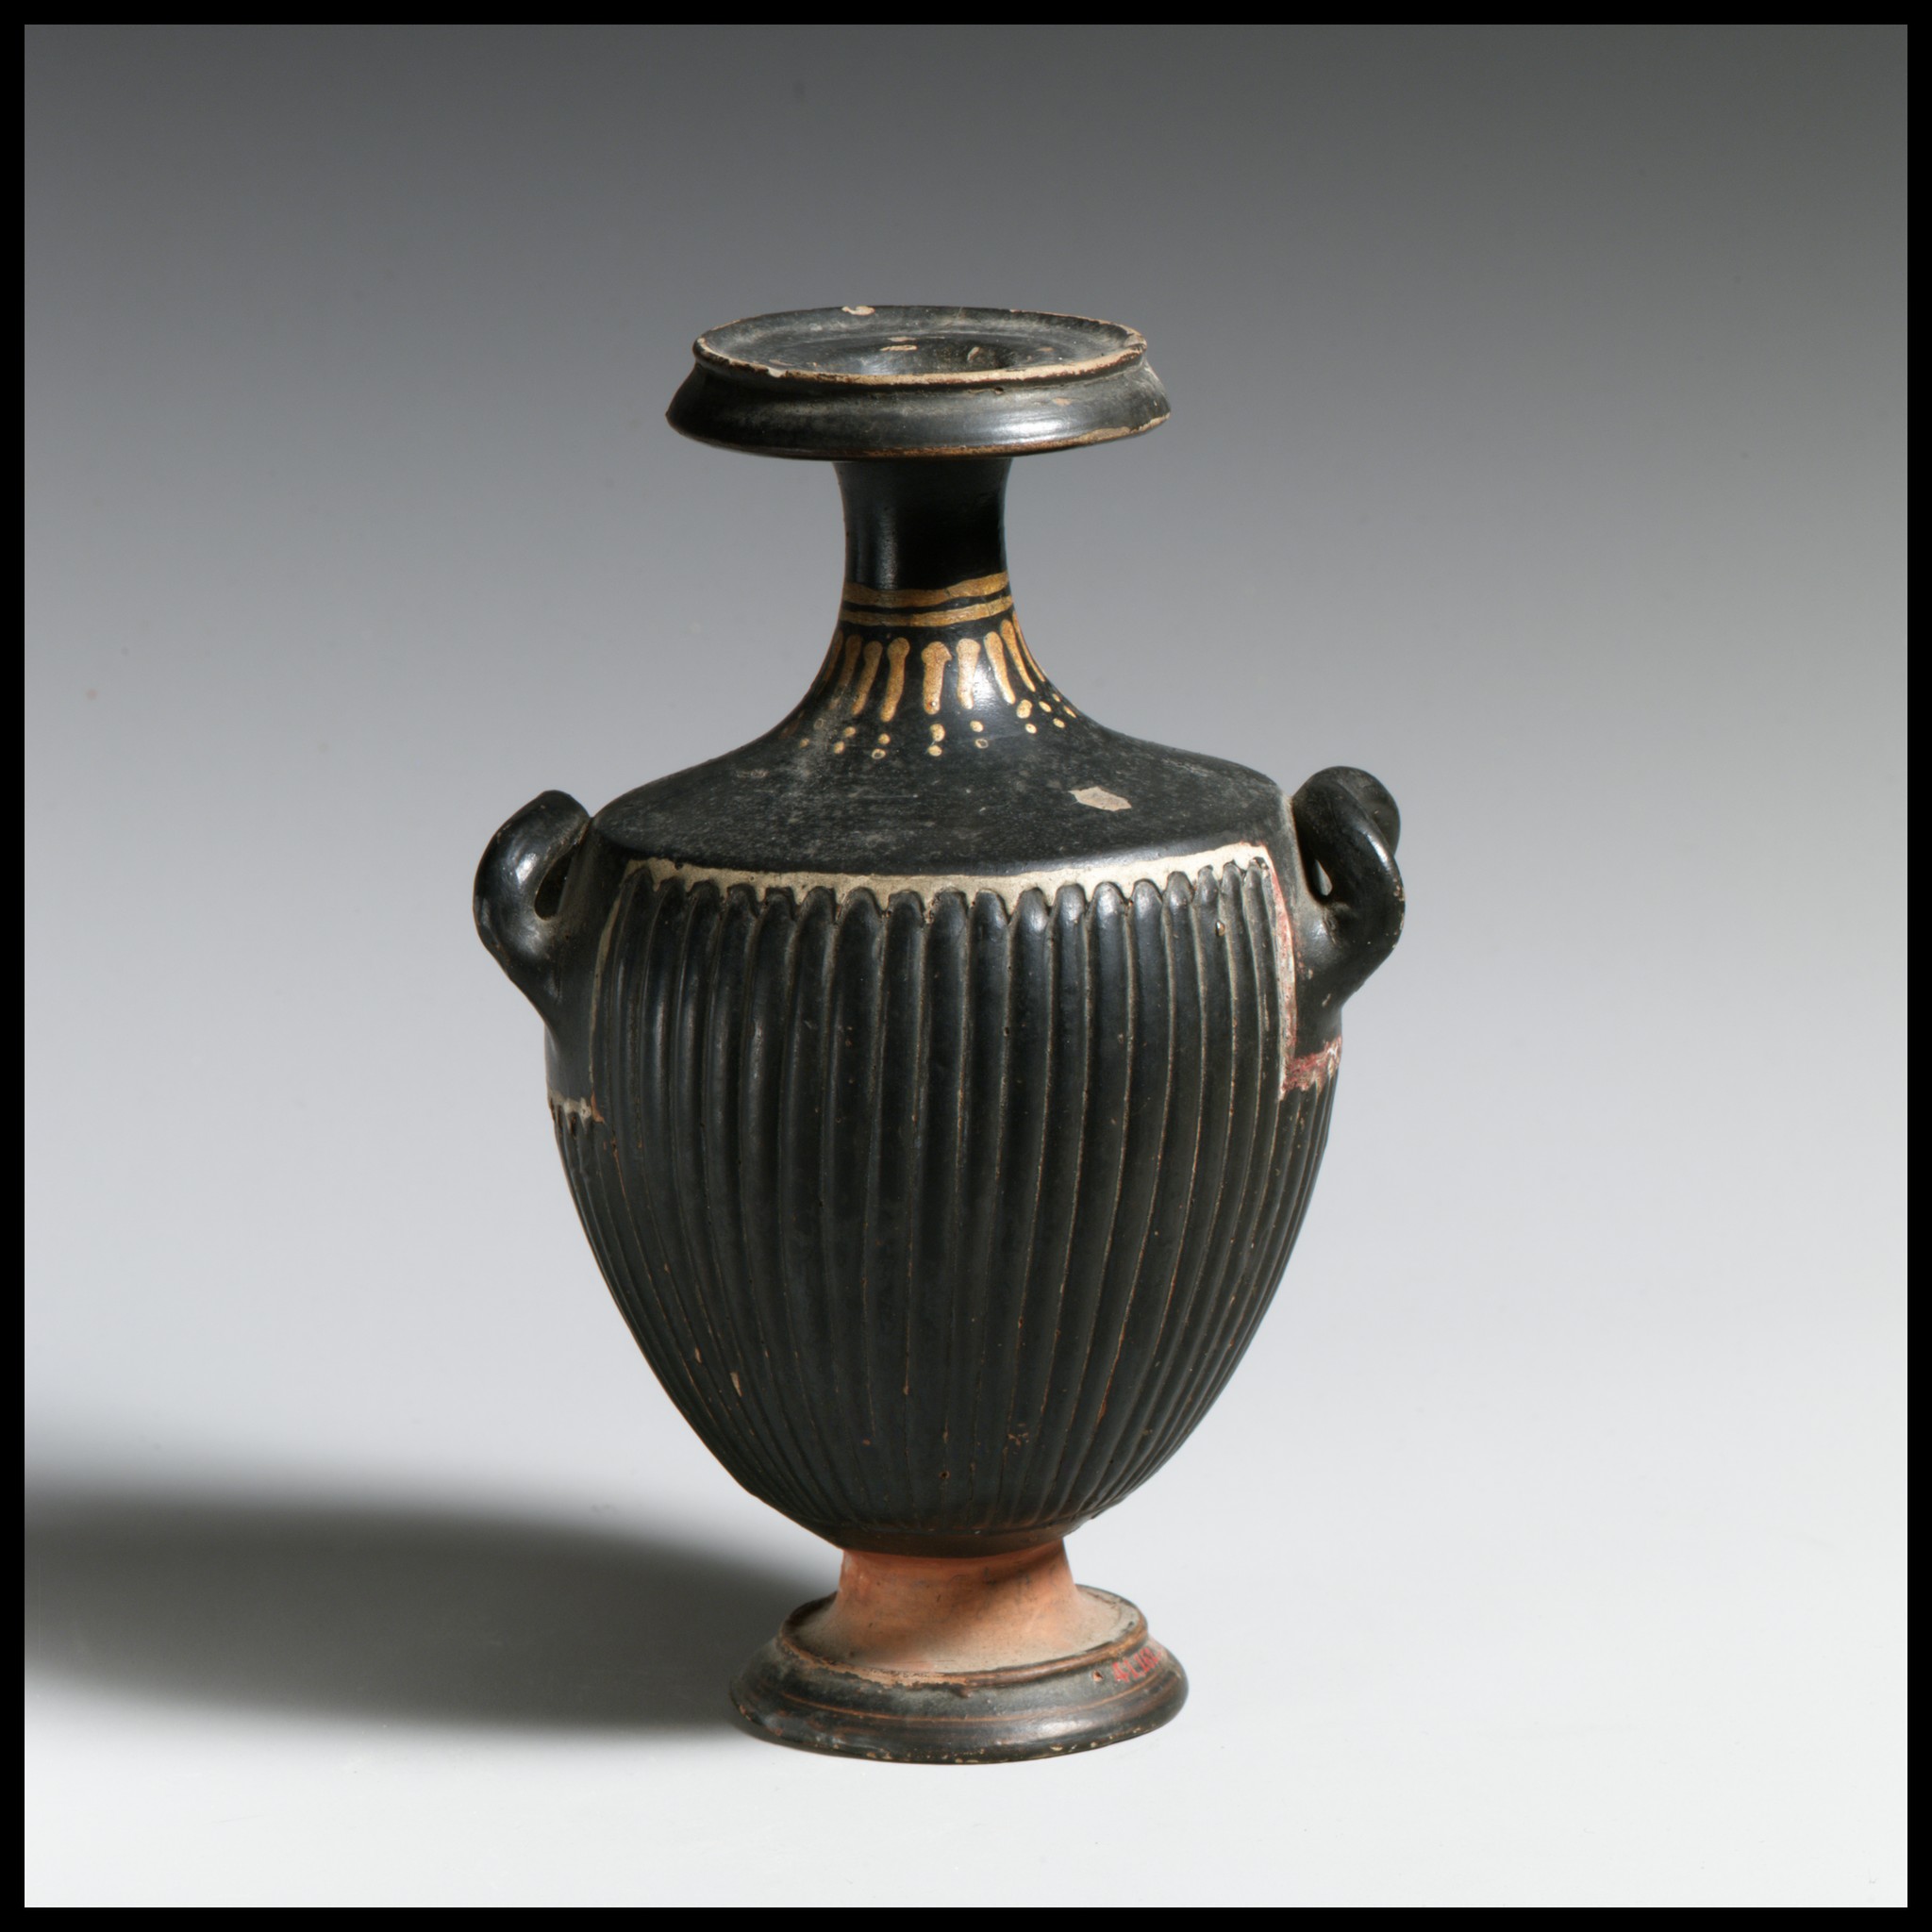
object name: hydria, kalpis, miniature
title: Terracotta miniature hydria: kalpis (water jar)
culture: greek, south italian, apulian, gnathian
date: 350-300 BCE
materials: terracotta